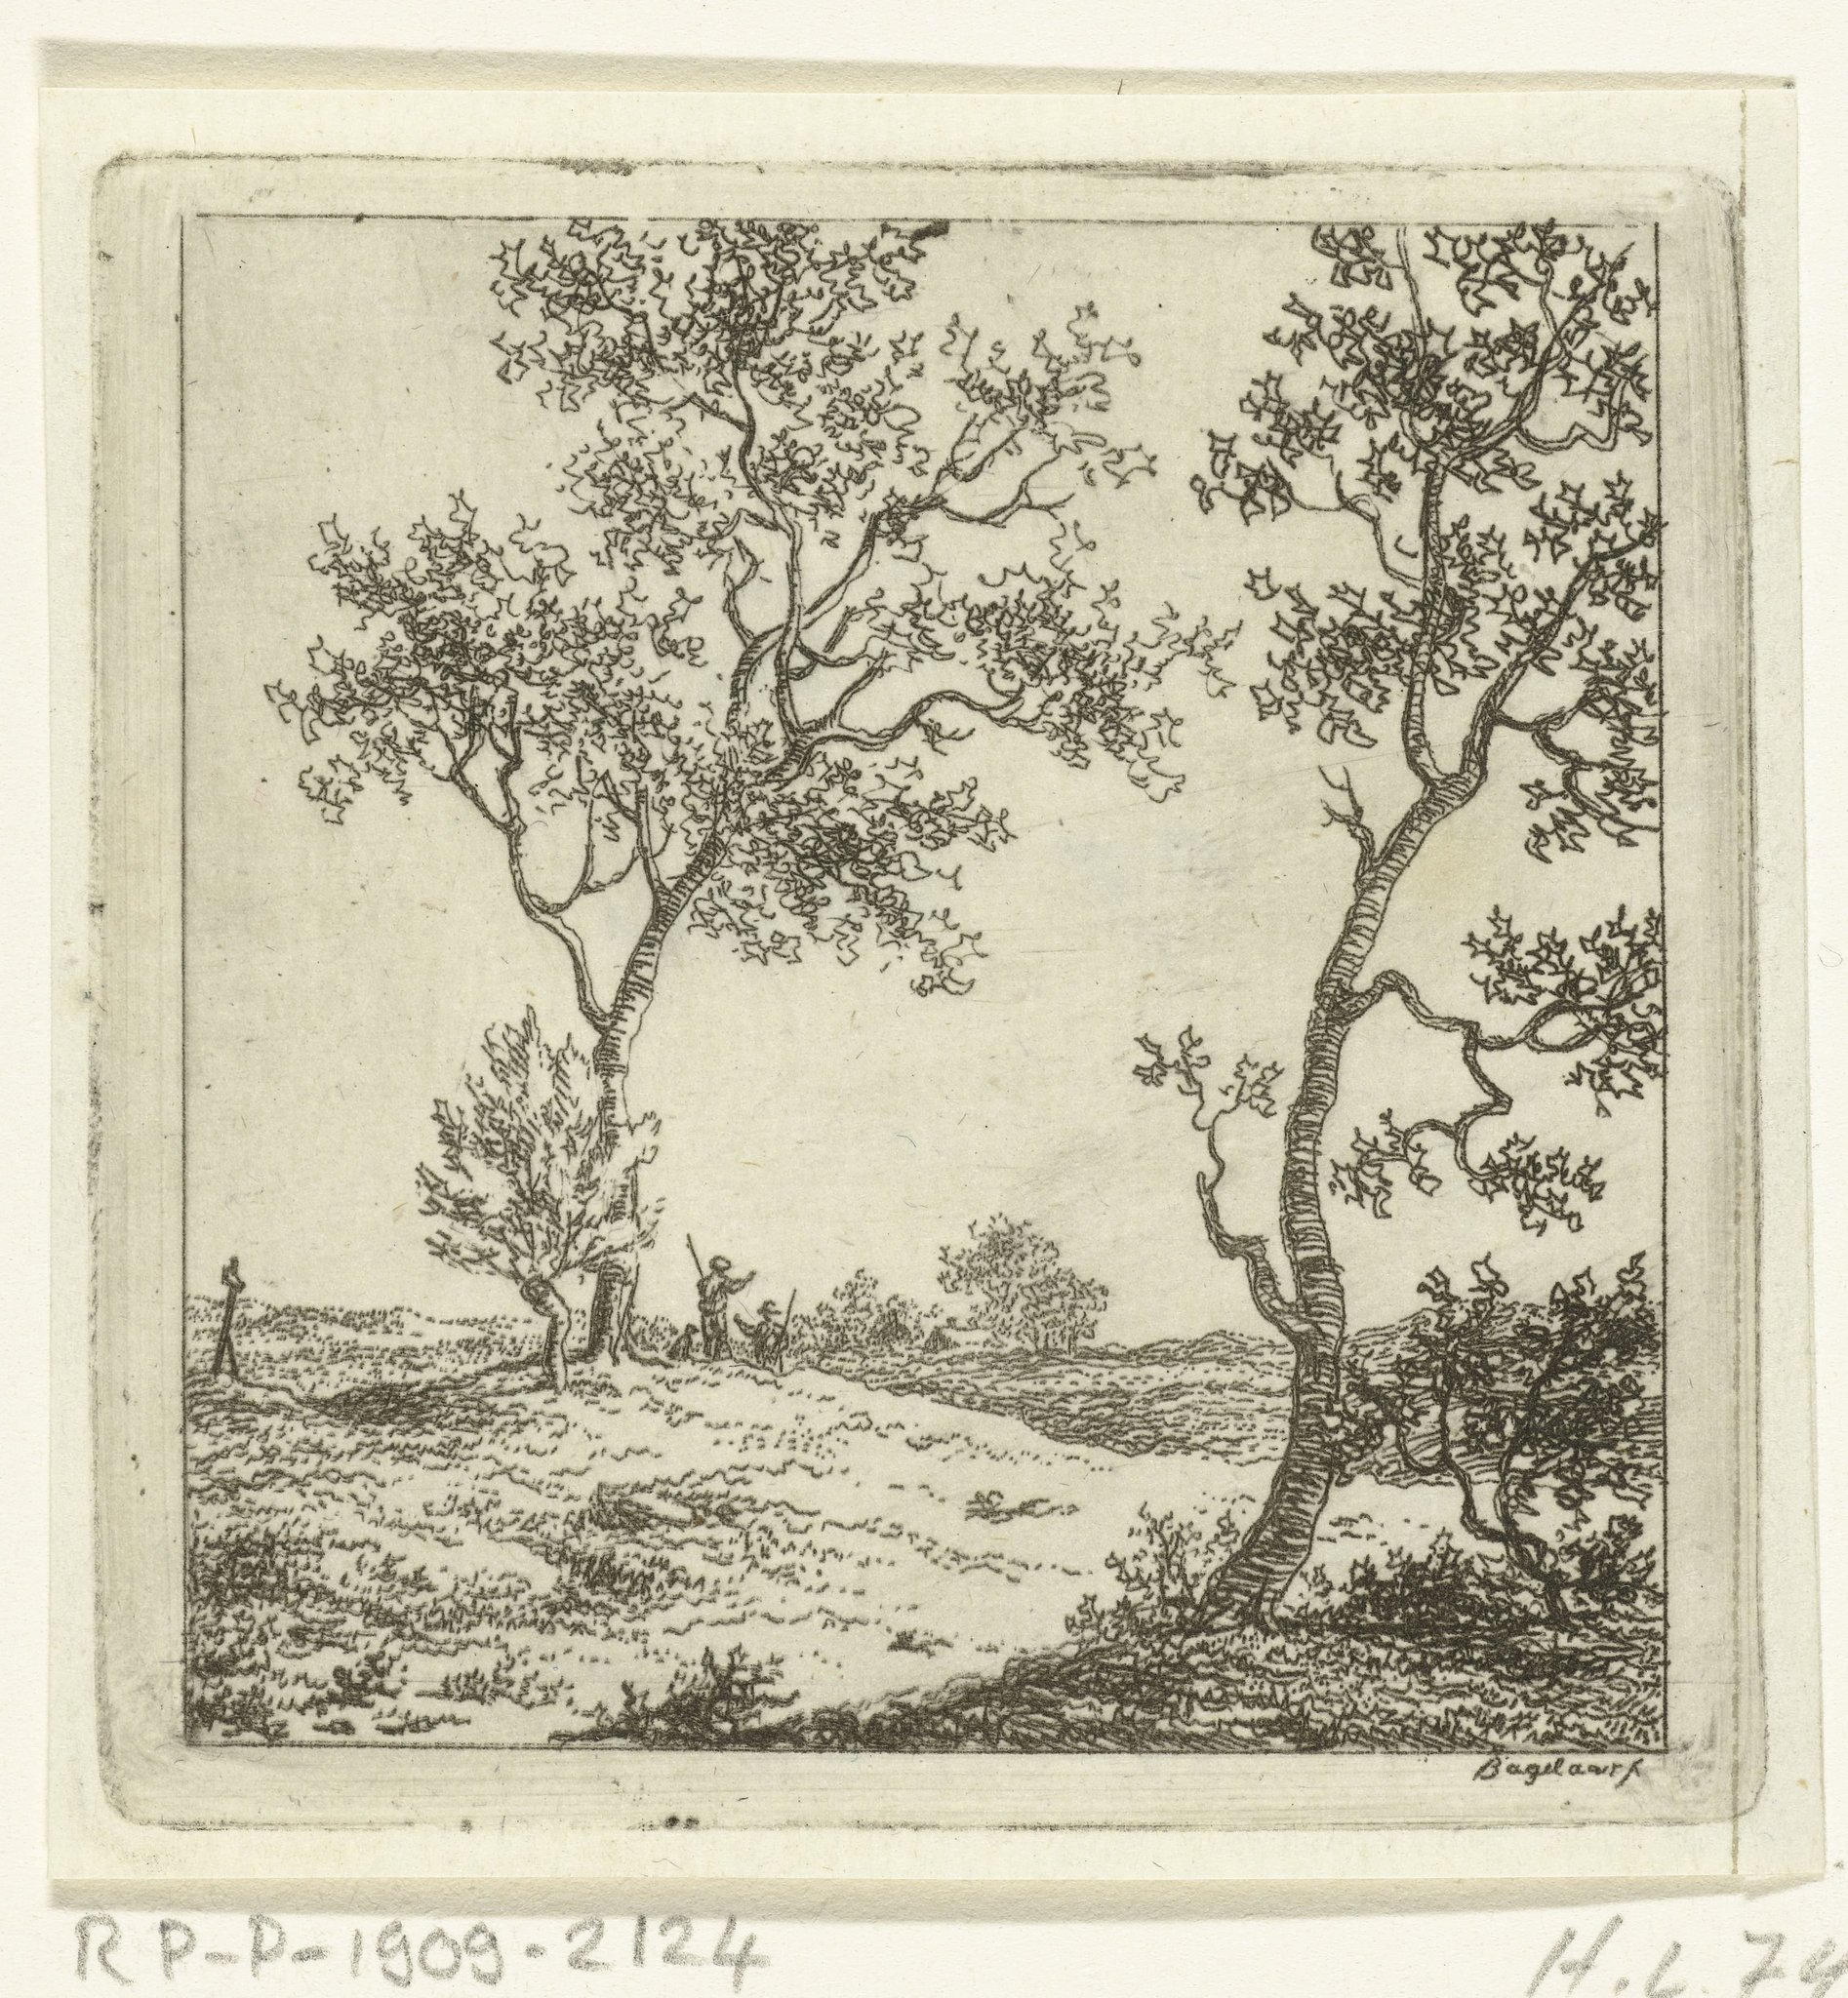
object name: print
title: Twee mannen met stokken in een landschap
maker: ernst willem jan bagelaar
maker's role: draughtsman, print maker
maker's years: 1775-1837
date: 1798-1837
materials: paper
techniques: etching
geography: netherlands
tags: landscapes in the temperate zone (+ landscape with figures, staffage)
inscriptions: collector's mark: Lugt 2228